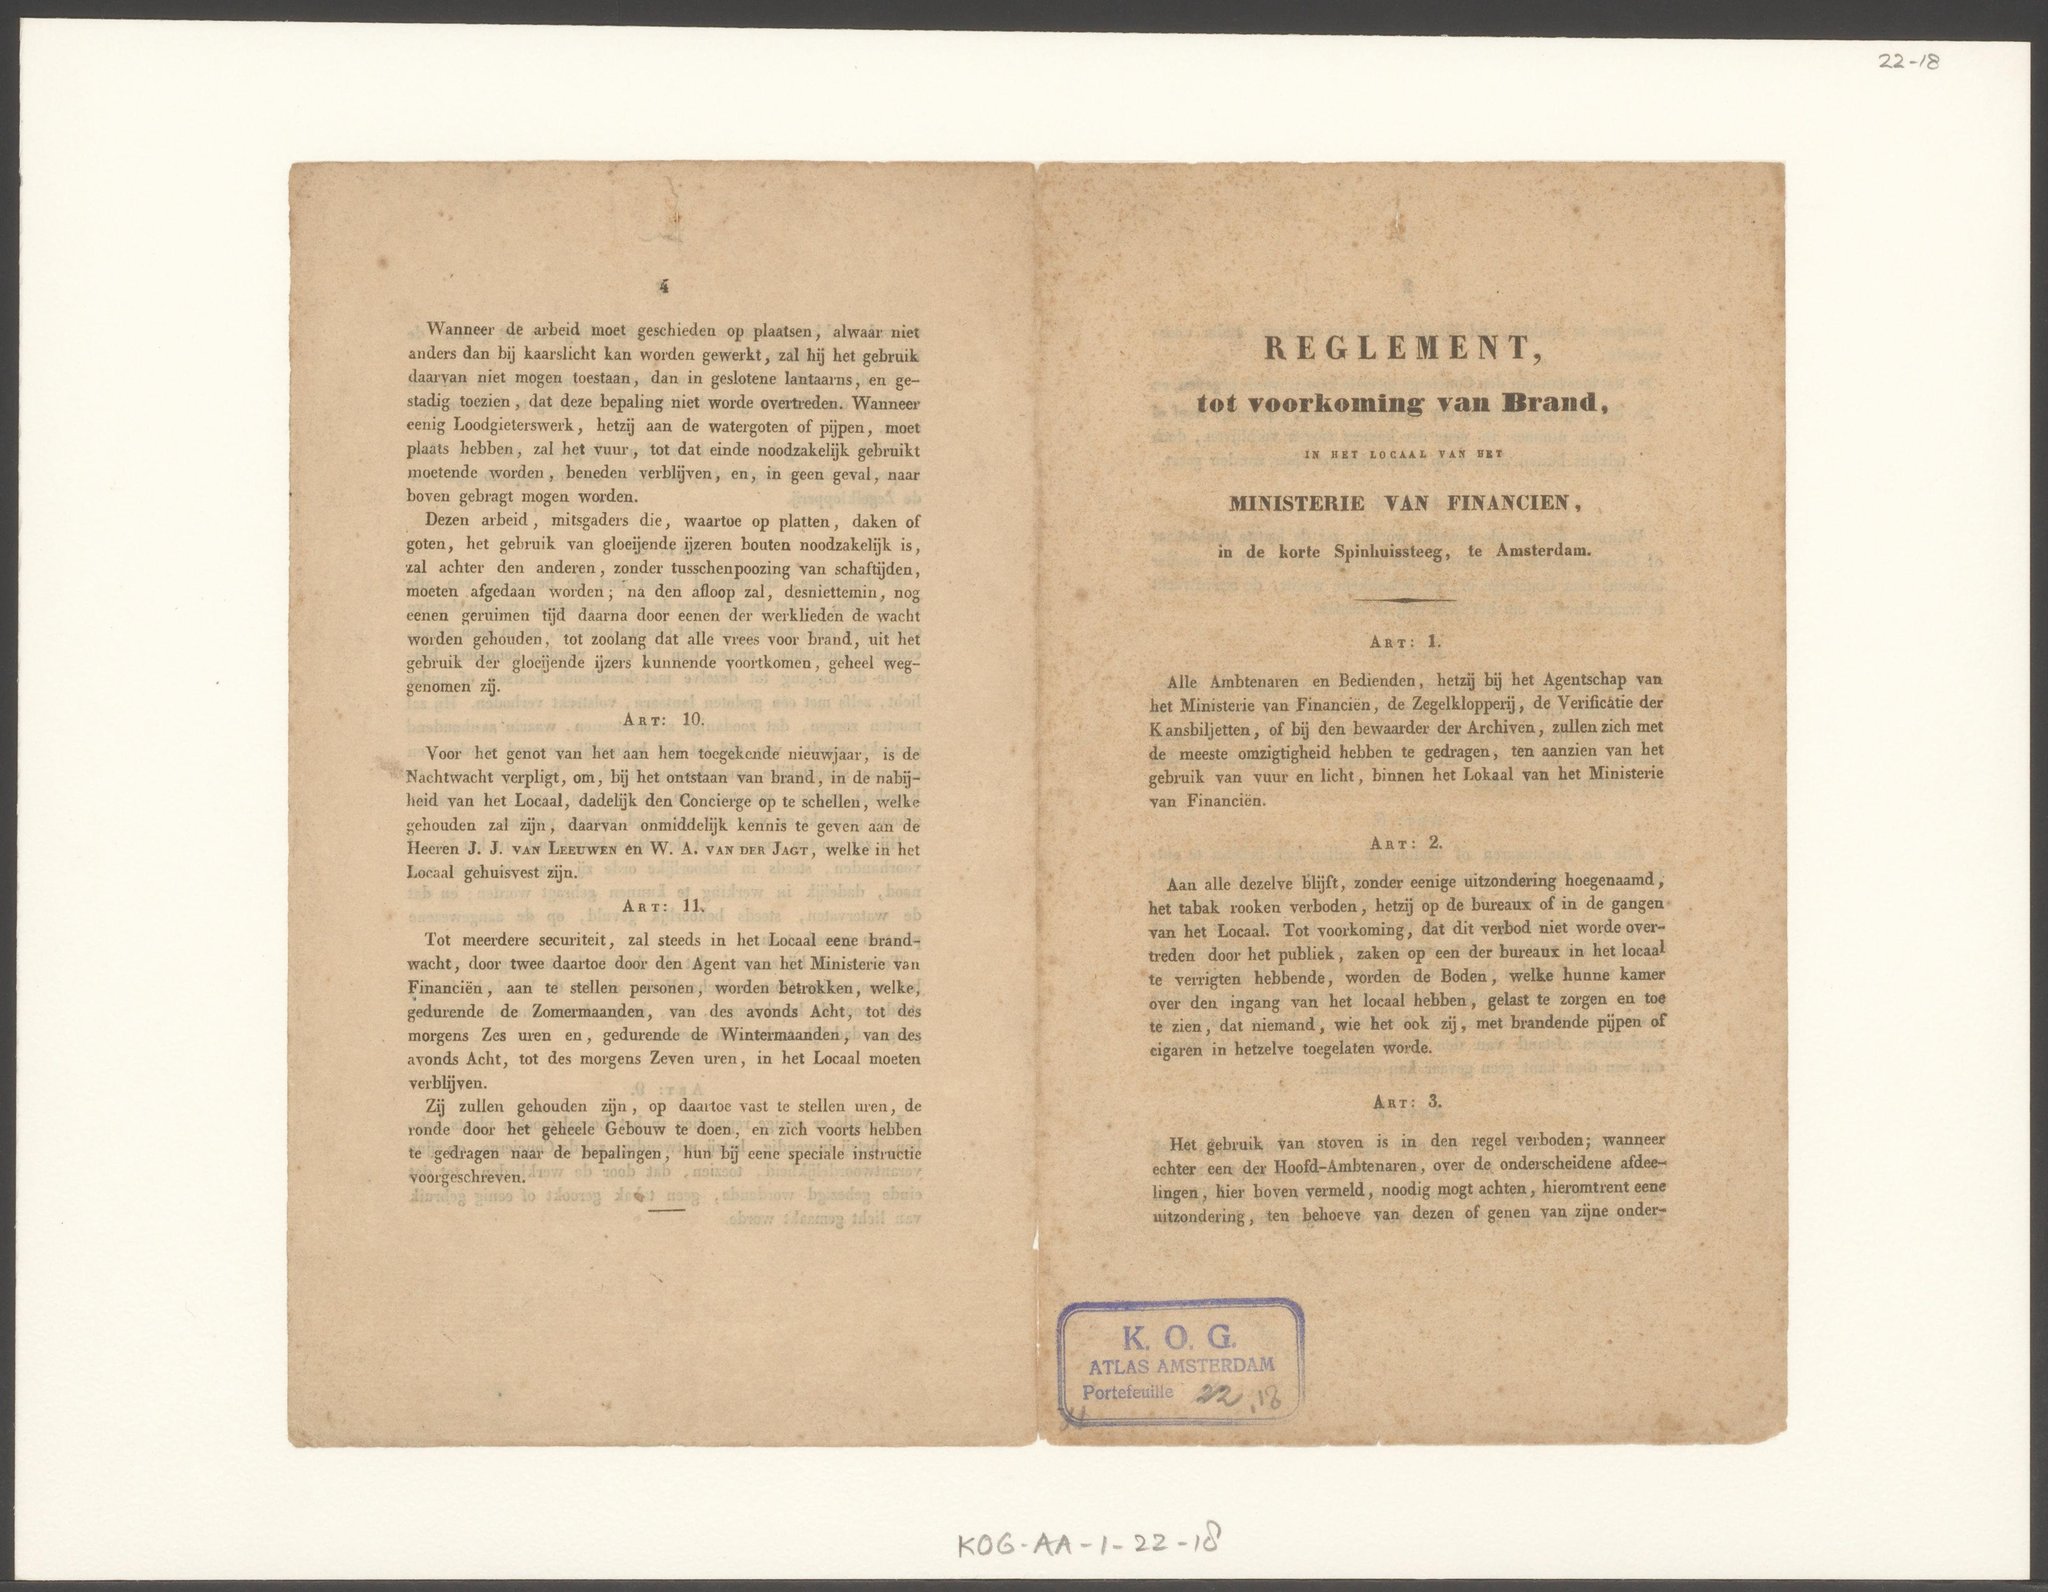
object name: document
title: Reglement, tot voorkoming van Brand, in het locaal van het Ministerie van Financien, in de korte Spinhuissteeg, te Amsterdam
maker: Anonymous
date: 1800-1899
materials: paper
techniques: letterpress printing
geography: netherlands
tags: fire-fighting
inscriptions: collector's mark: Lugt 1641b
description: Onderwerpsrubriek binnen de Atlas Amsterdam: Gemeentewerken: A. Brandweer.